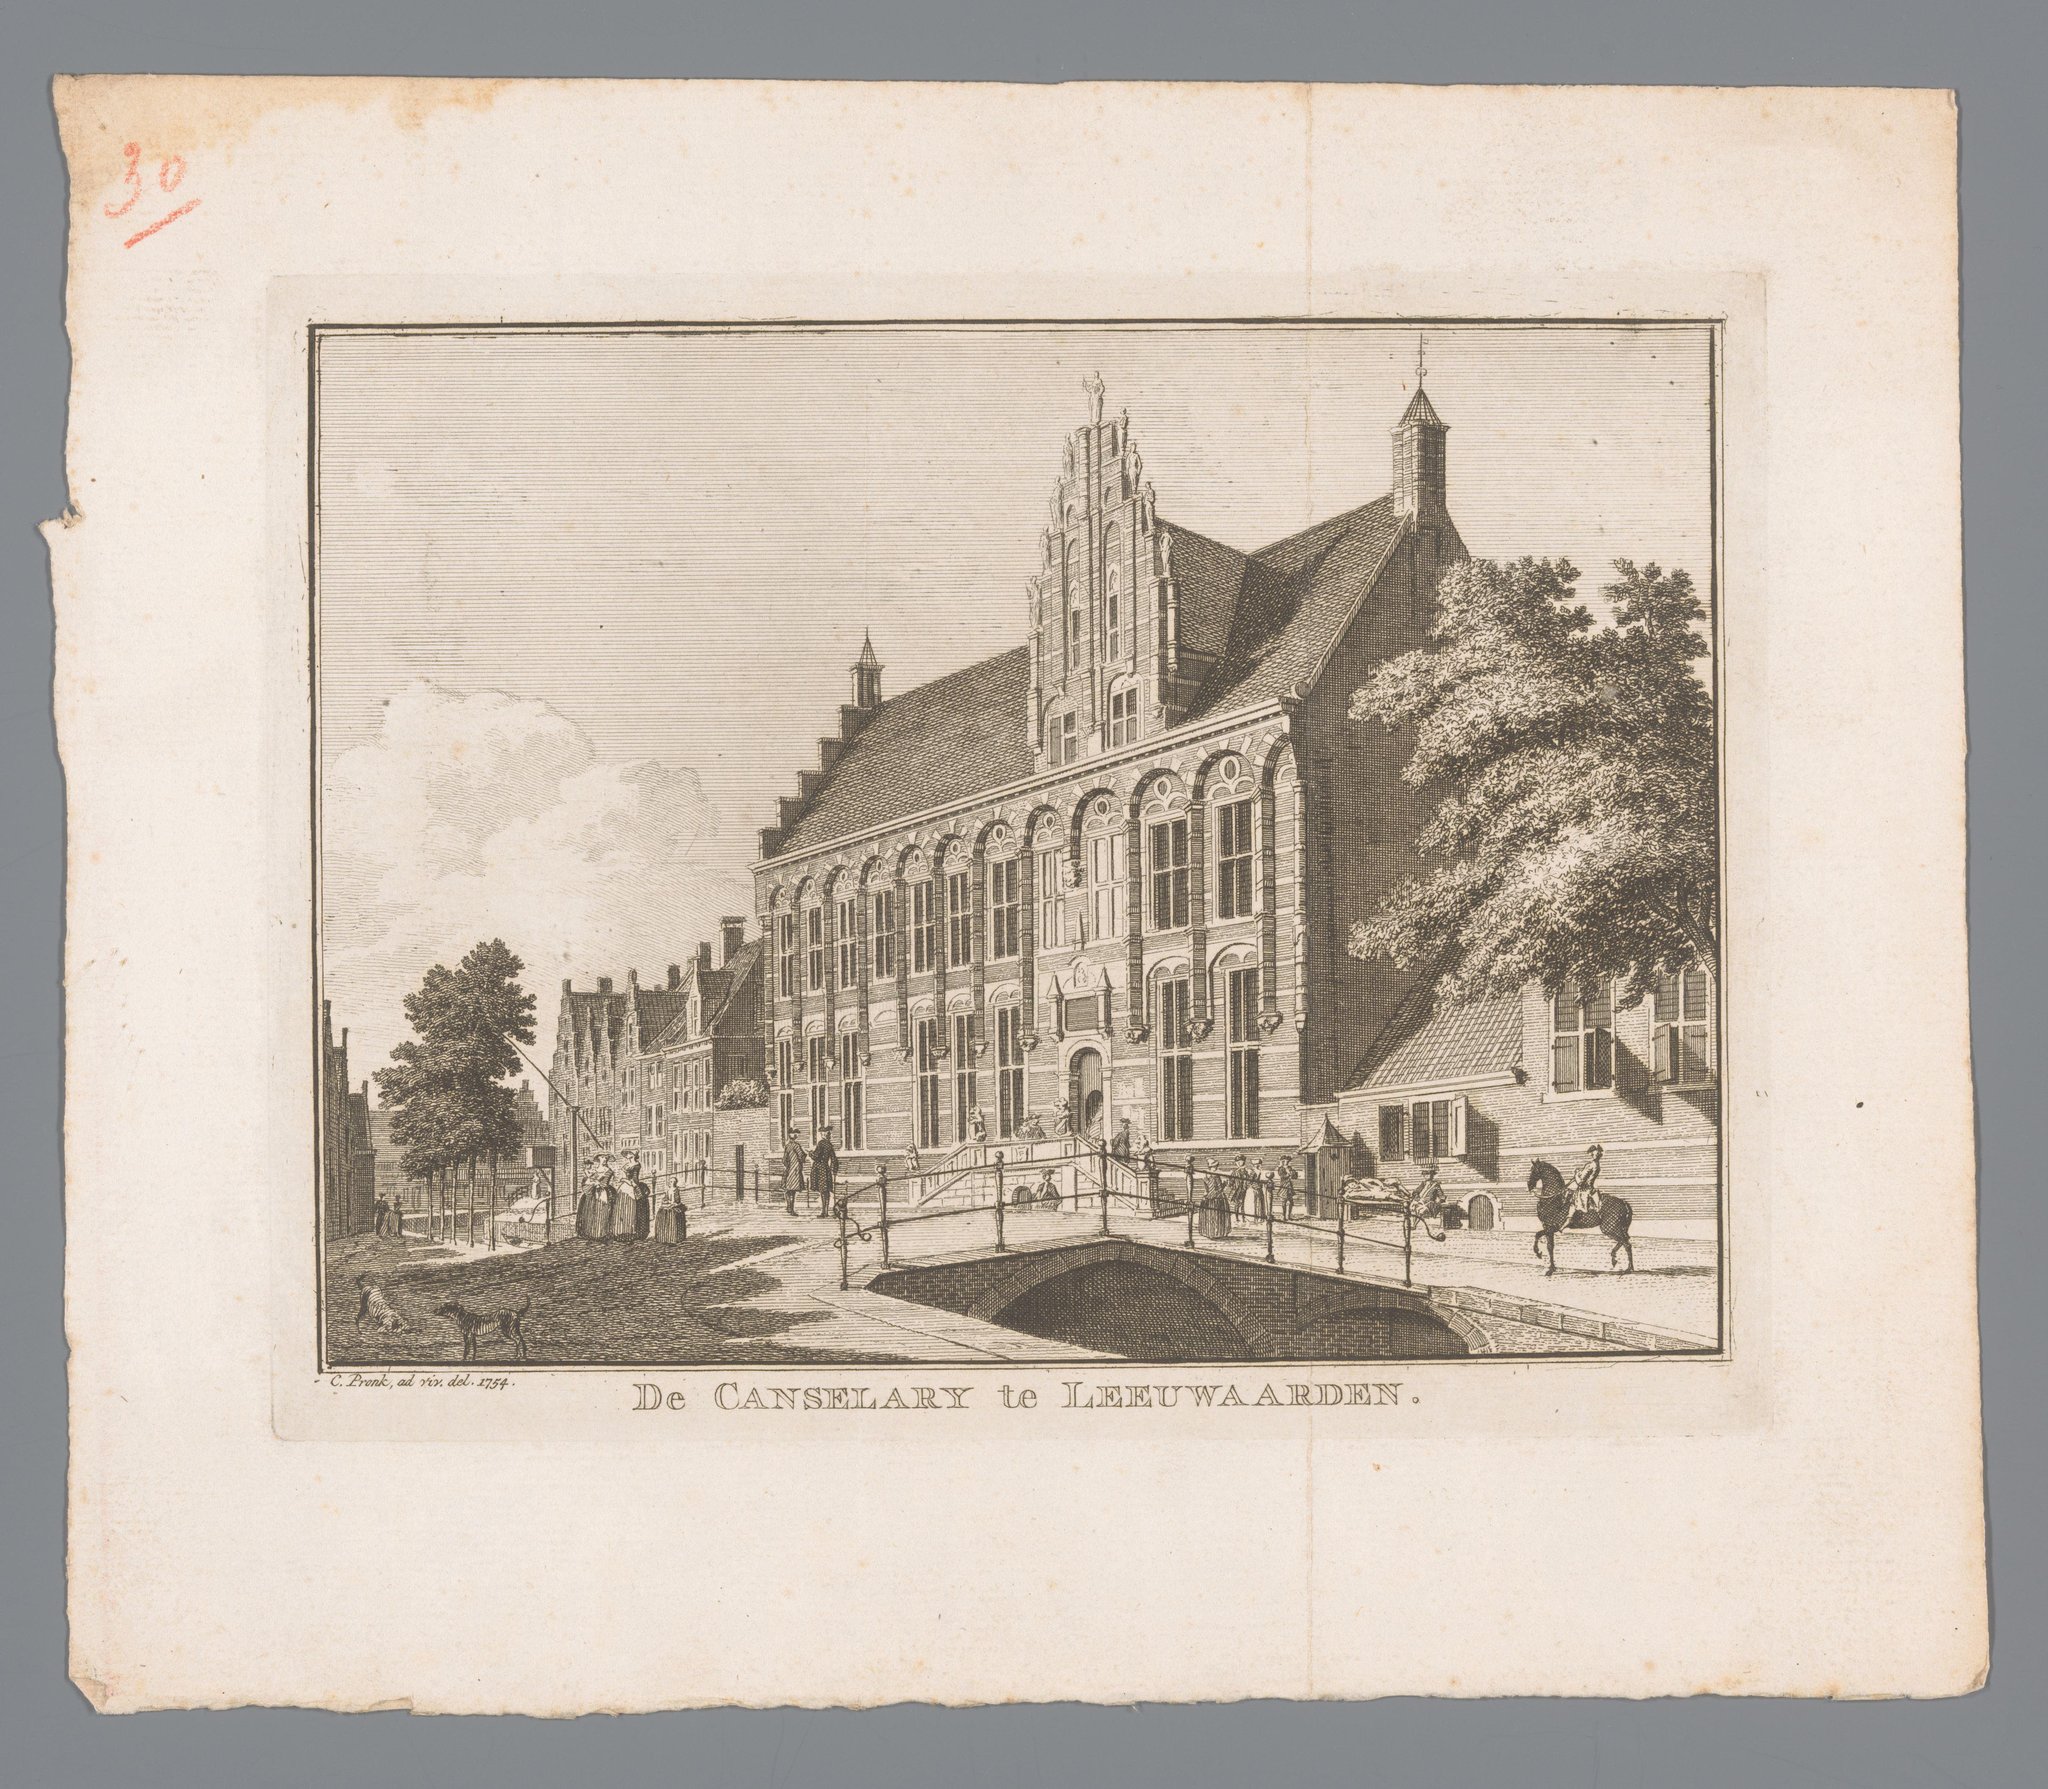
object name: print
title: De Canselary te Leeuwaarden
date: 1754-1800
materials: paper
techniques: etching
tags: city-view, and landscape with man-made constructions, bridge in city across river, canal, etc.